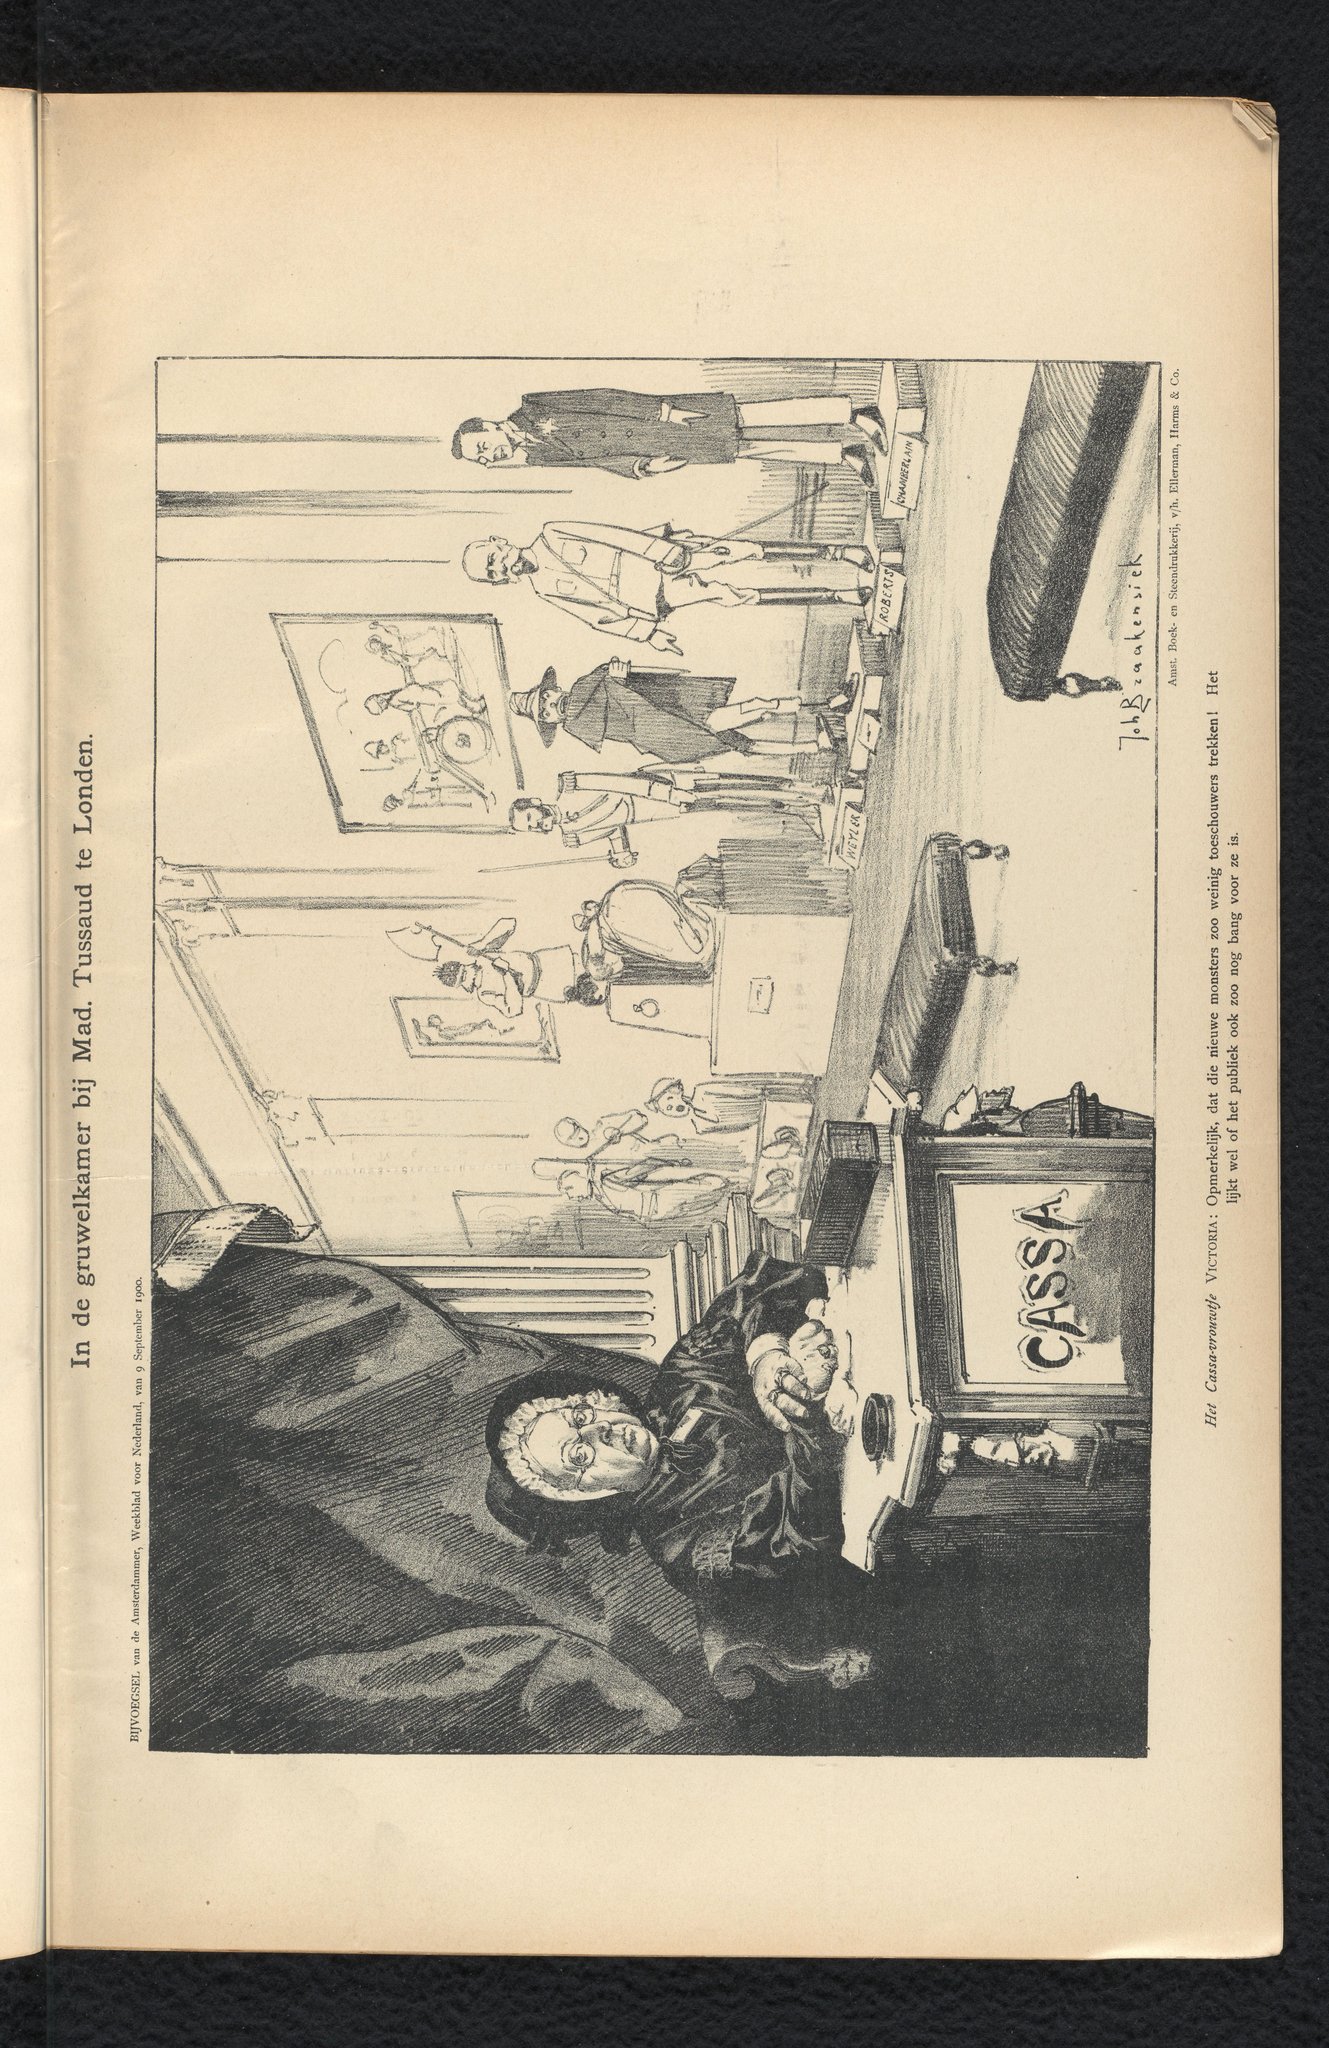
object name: cartoon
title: In de gruwelkamer bij Mad. Tussaud te Londen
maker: johan braakensiek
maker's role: draughtsman, print maker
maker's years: 1858-1940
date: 1900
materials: paper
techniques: lithograph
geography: netherlands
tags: victoria (koningin van het verenigd koninkrijk en keizerin van india), wax-figure cabinet, horrors of war, political caricatures and satires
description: Koningin Victoria achter de kassa bij de ingang van het wassenbeeldenmuseum van Madame Tussaud in Londen beklaagt dat er nog maar weinig belangstelling is voor de nieuwe beelden van generaal Roberts en van Joseph Chamberlain, 'monsters' uit de Boerenoorlog.